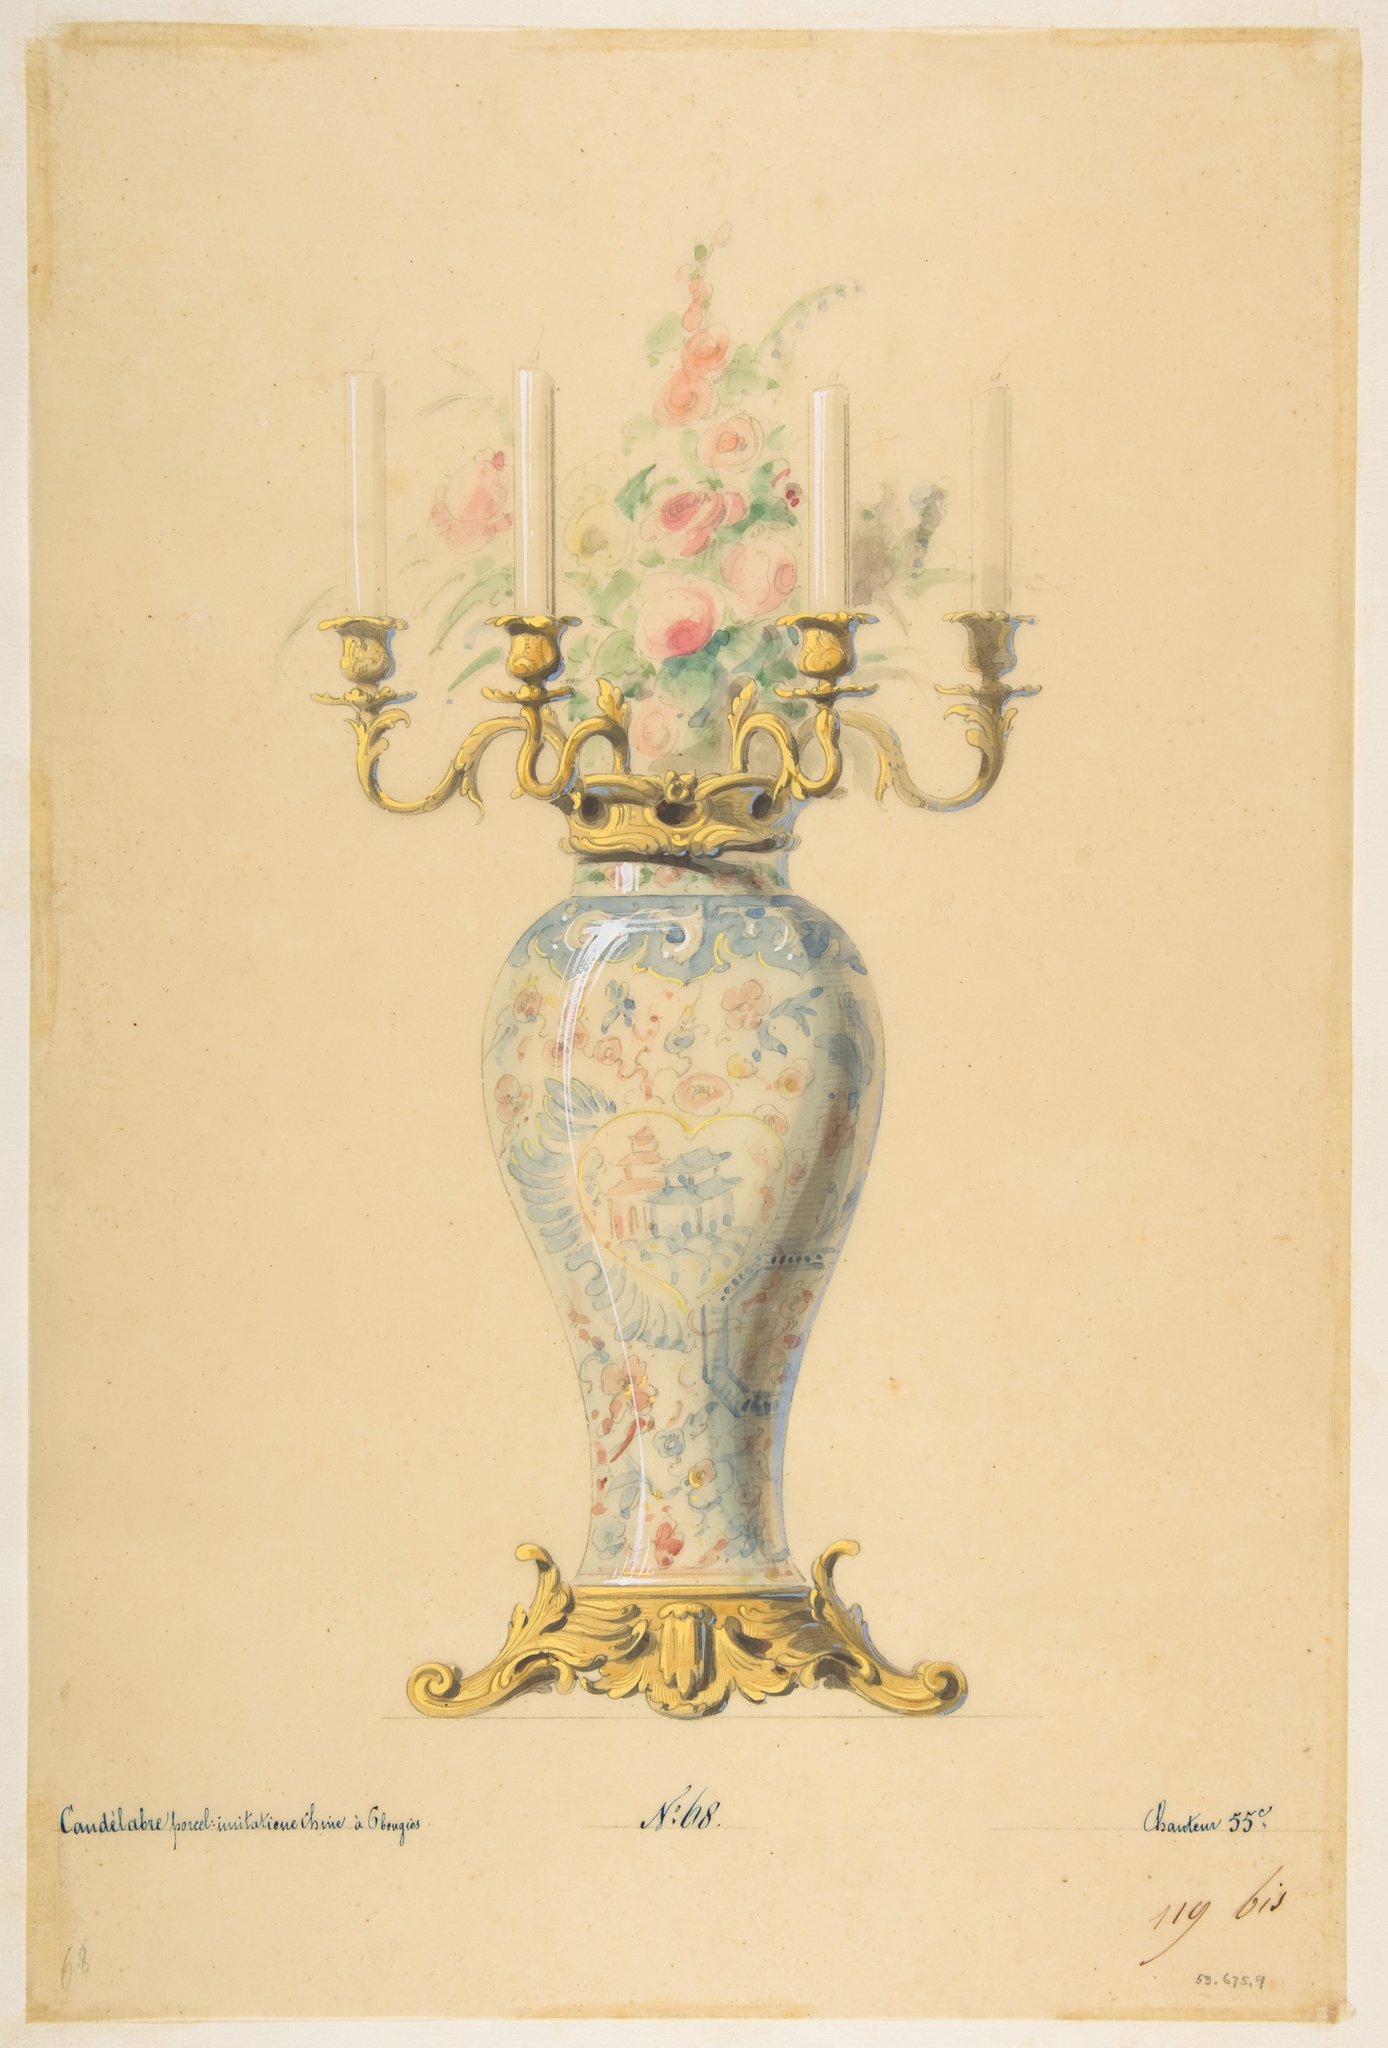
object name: drawing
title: Design for a Vase with Candelabra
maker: anonymous, french, 19th century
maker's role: artist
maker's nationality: french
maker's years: 1800-1900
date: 1801-1900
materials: gouache, graphite, watercolor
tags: candelabra